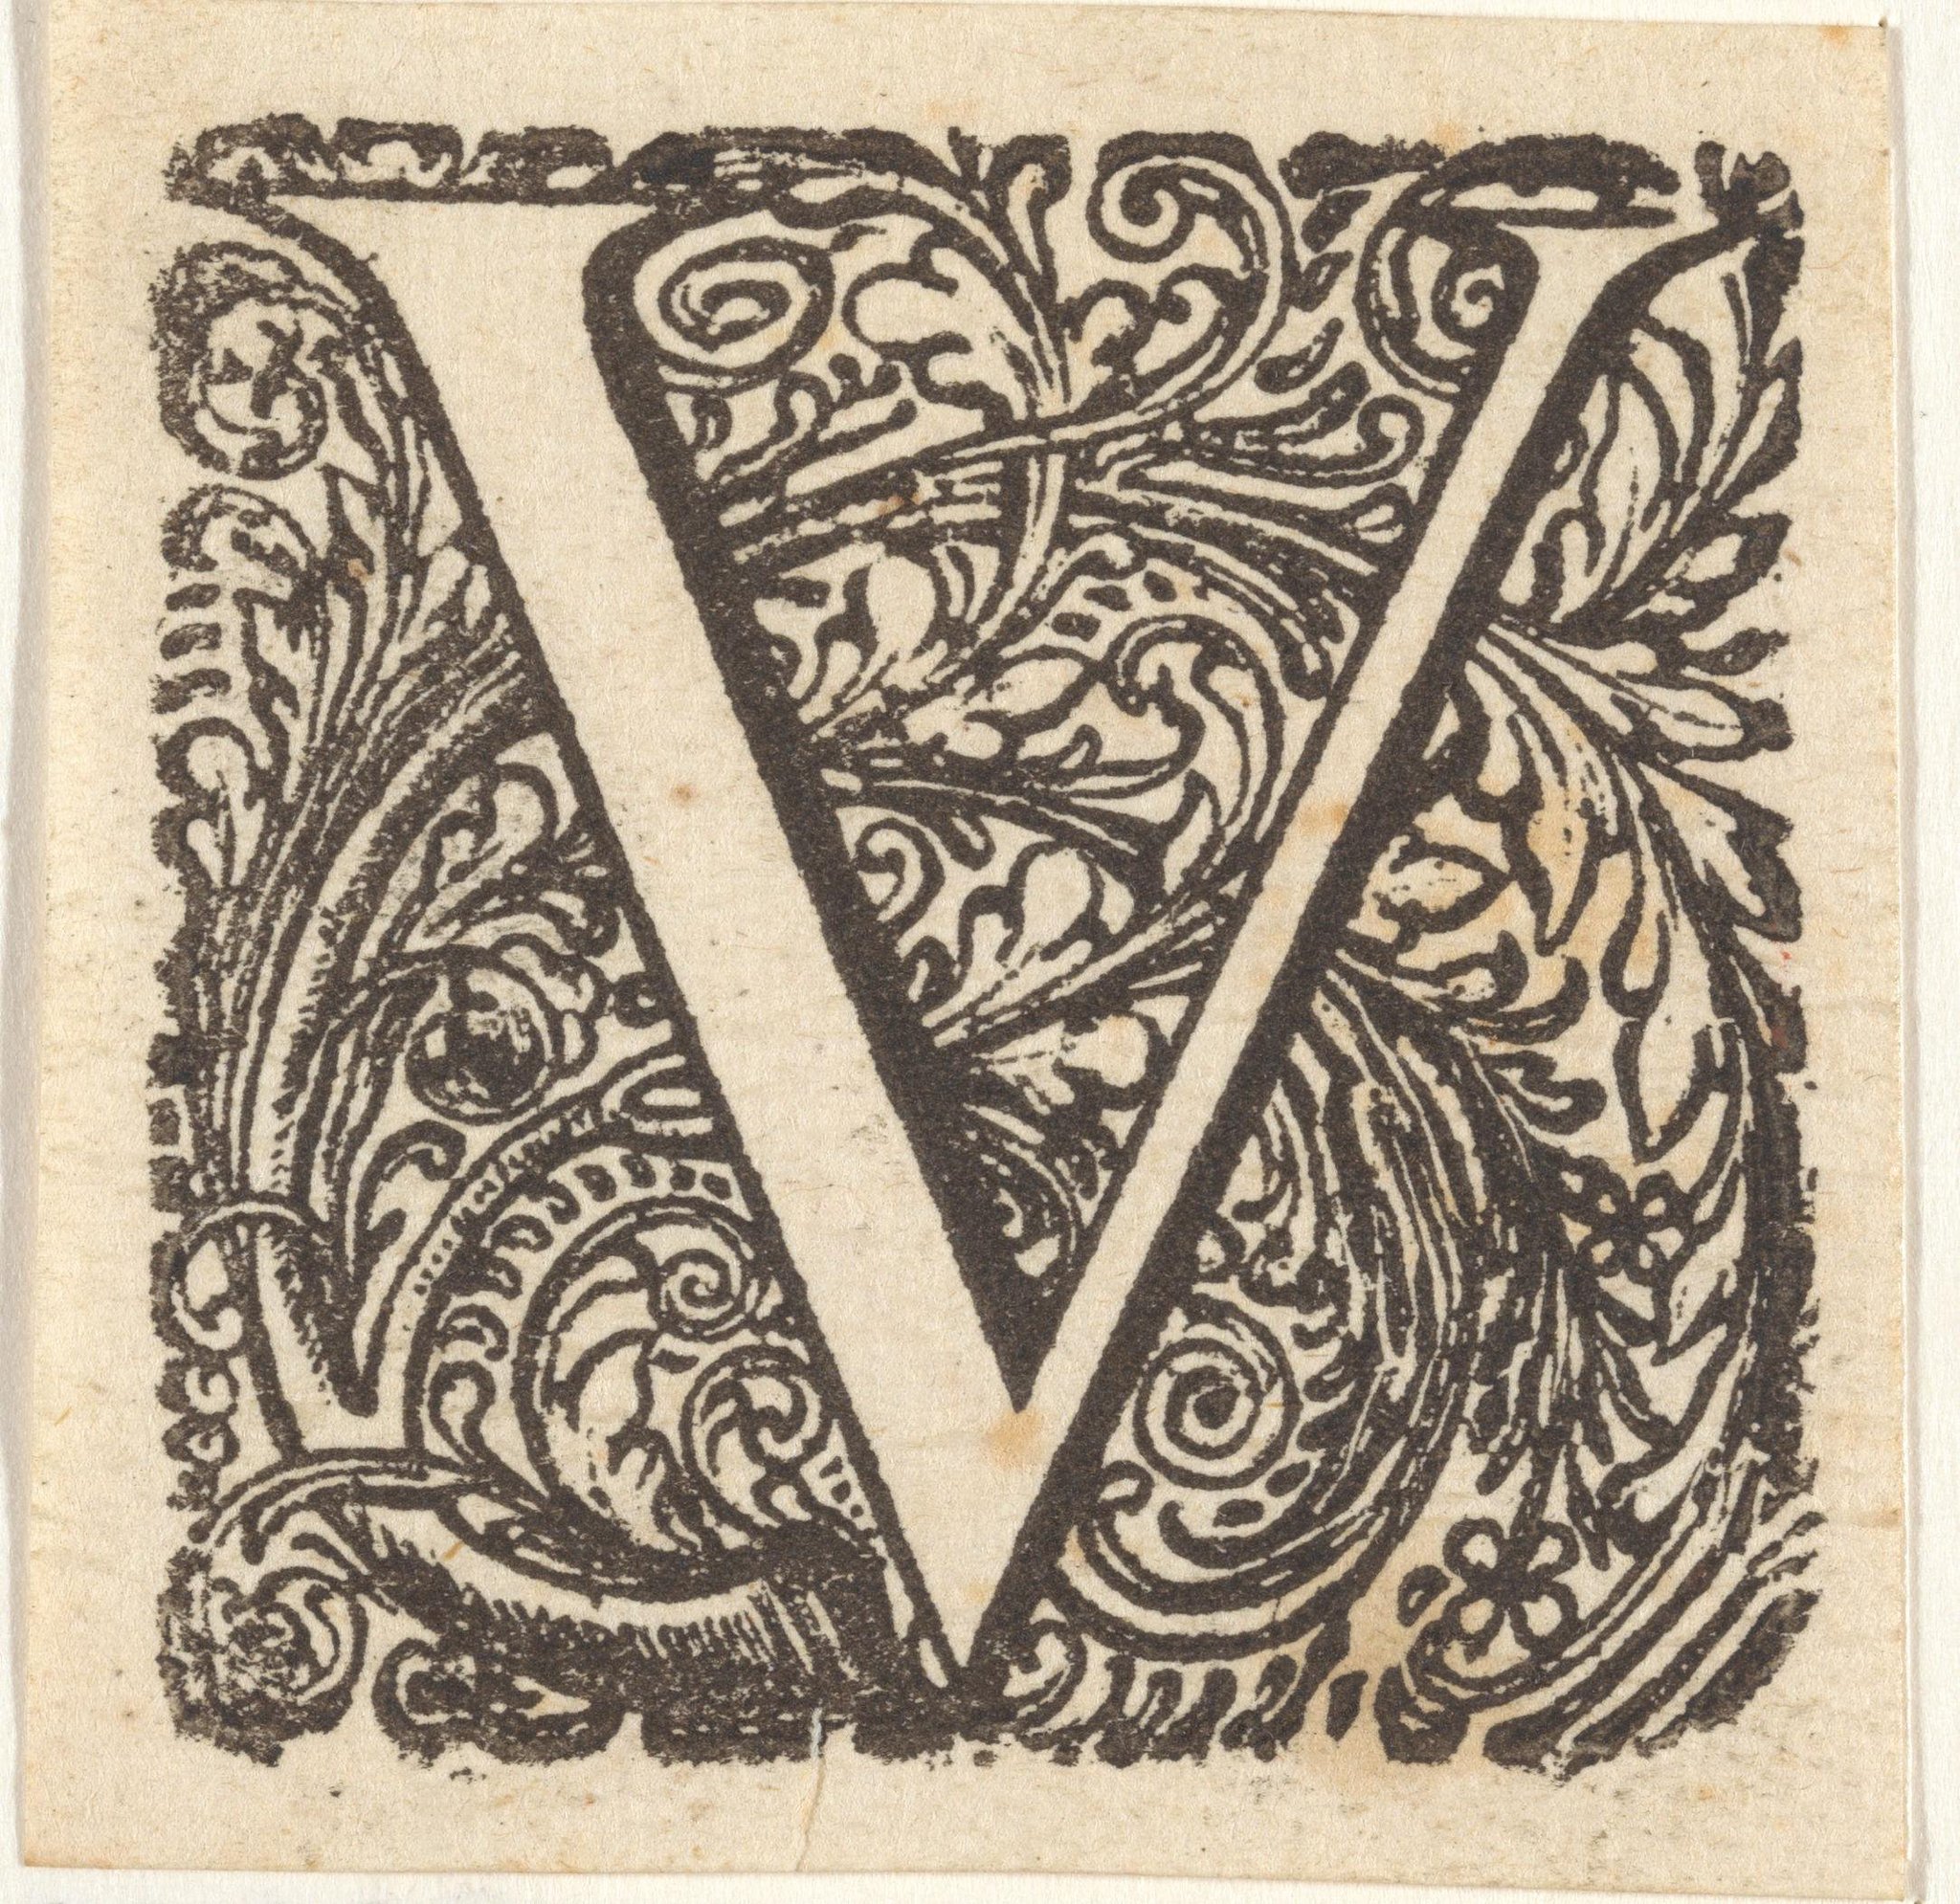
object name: print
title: Letter V in een geornamenteerde omlijsting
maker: Anonymous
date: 1600-1699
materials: paper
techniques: woodcut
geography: netherlands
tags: fancy letters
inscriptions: collector's mark: Lugt 240